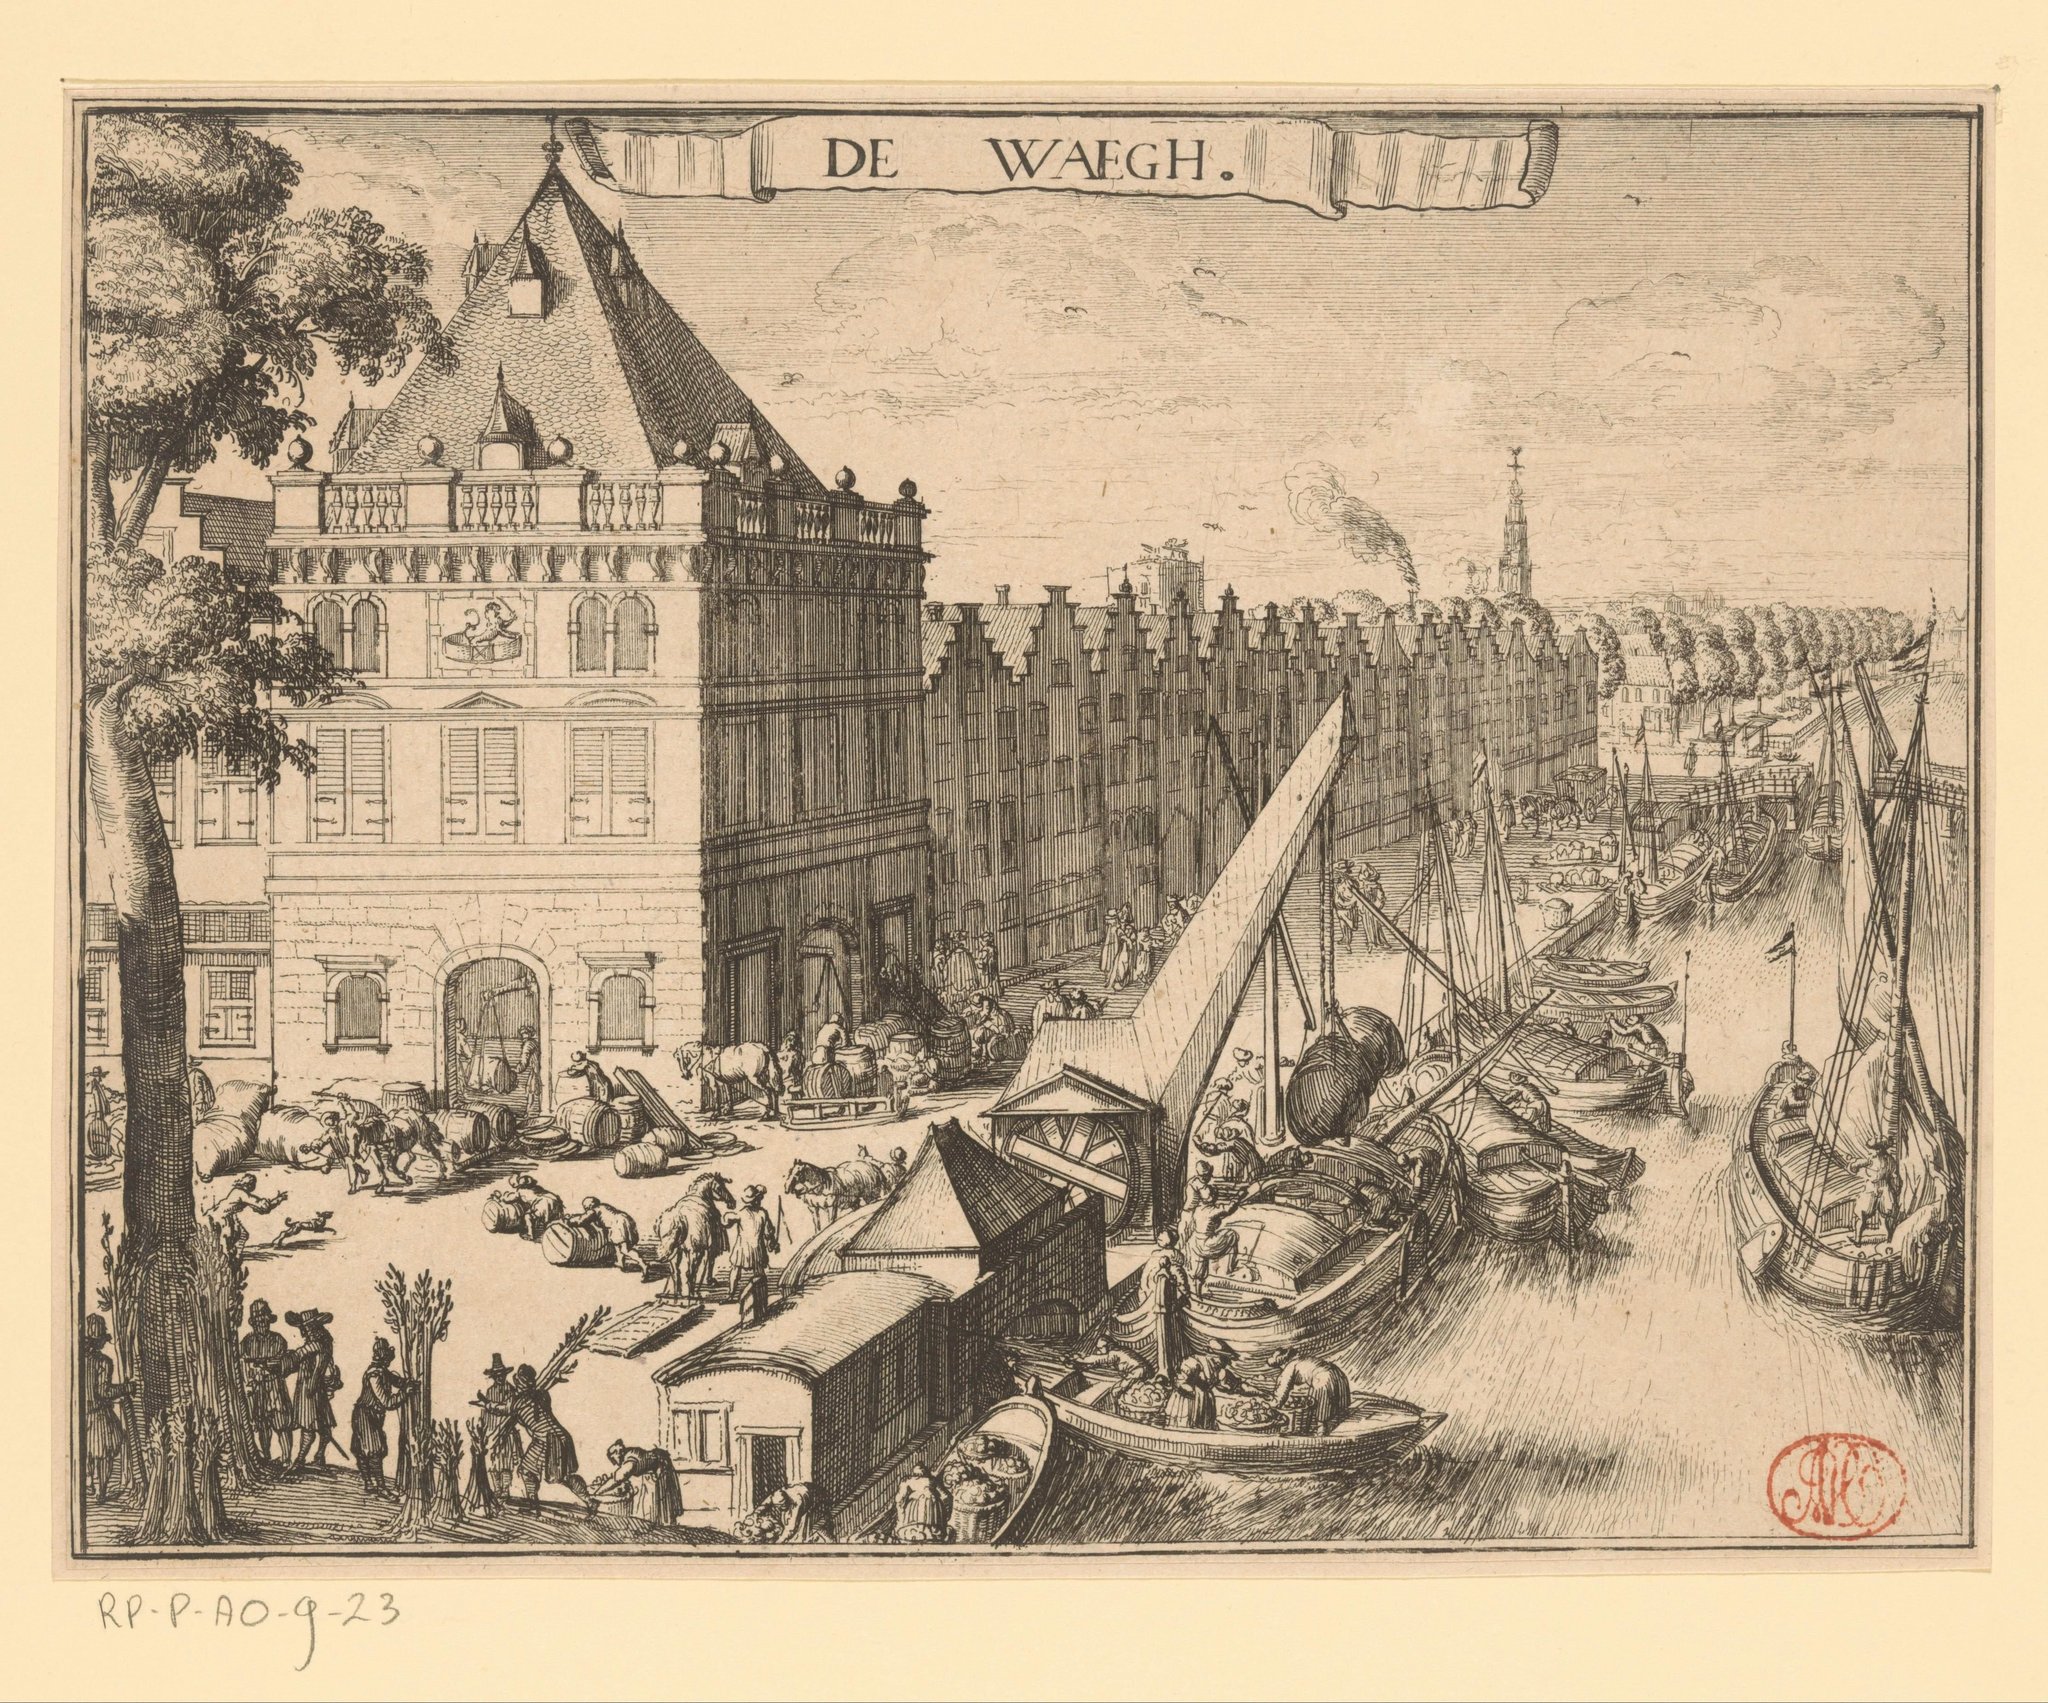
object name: print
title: De Waegh.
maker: romeyn de hooghe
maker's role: draughtsman, goldsmith, painter, print maker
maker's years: 1645-1708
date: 1688-1689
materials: paper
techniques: etching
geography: haarlem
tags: weigh-house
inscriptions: collector's mark: Lugt 195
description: Gezicht op de Waag te Haarlem aan het Spaarne, met vele handelaars die hun koopwaren per boot of ton erheen brengen. Dit blad maakt deel uit van een omvangrijke prent met een grote plattegrond van Haarlem, omgeven door zeven wapenschilden, een profiel van de stad, gezichten op markante Haarlemse gebouwen en voorstellingen van belangrijke momenten uit de Haarlemse geschiedenis.